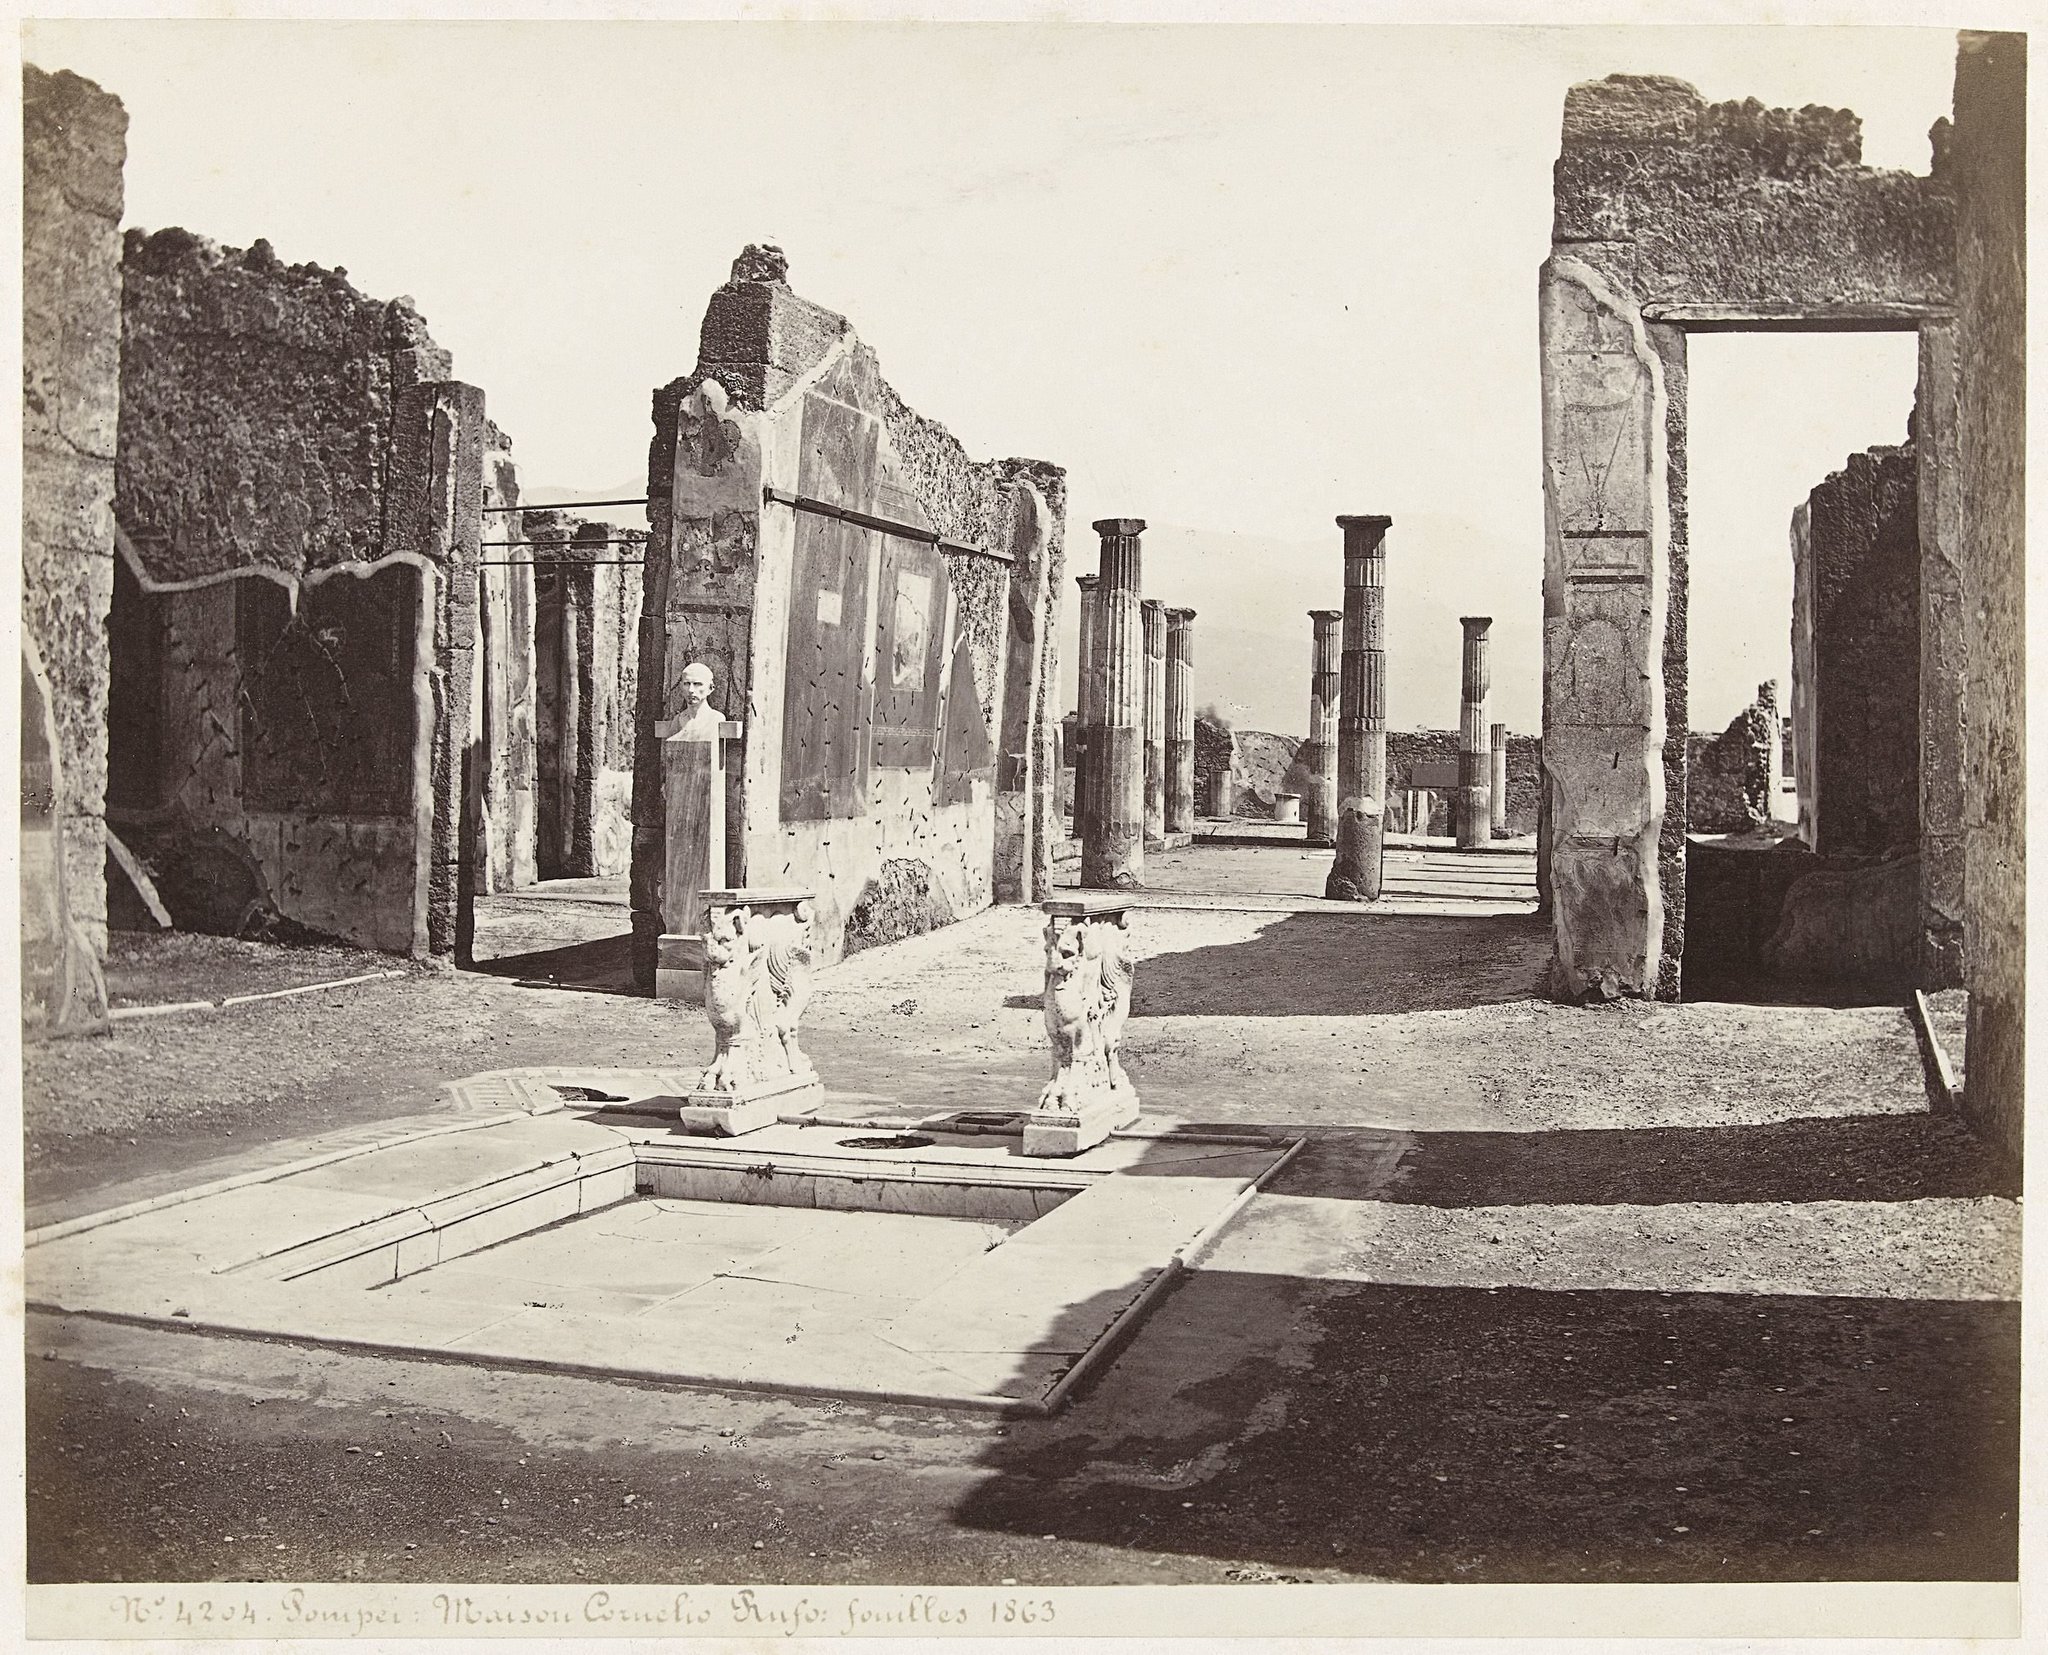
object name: photograph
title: Restanten van het huis van Cornelio Rufo in Pompeï, Italië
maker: Anonymous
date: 1851-1900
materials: cardboard, paper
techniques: albumen print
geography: pompeii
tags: excavation ~ archaeology, ruin of a dwelling, house, castle, etc., pompeii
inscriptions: number: ‘41’, number: ‘10’, number: ‘No. 4234’